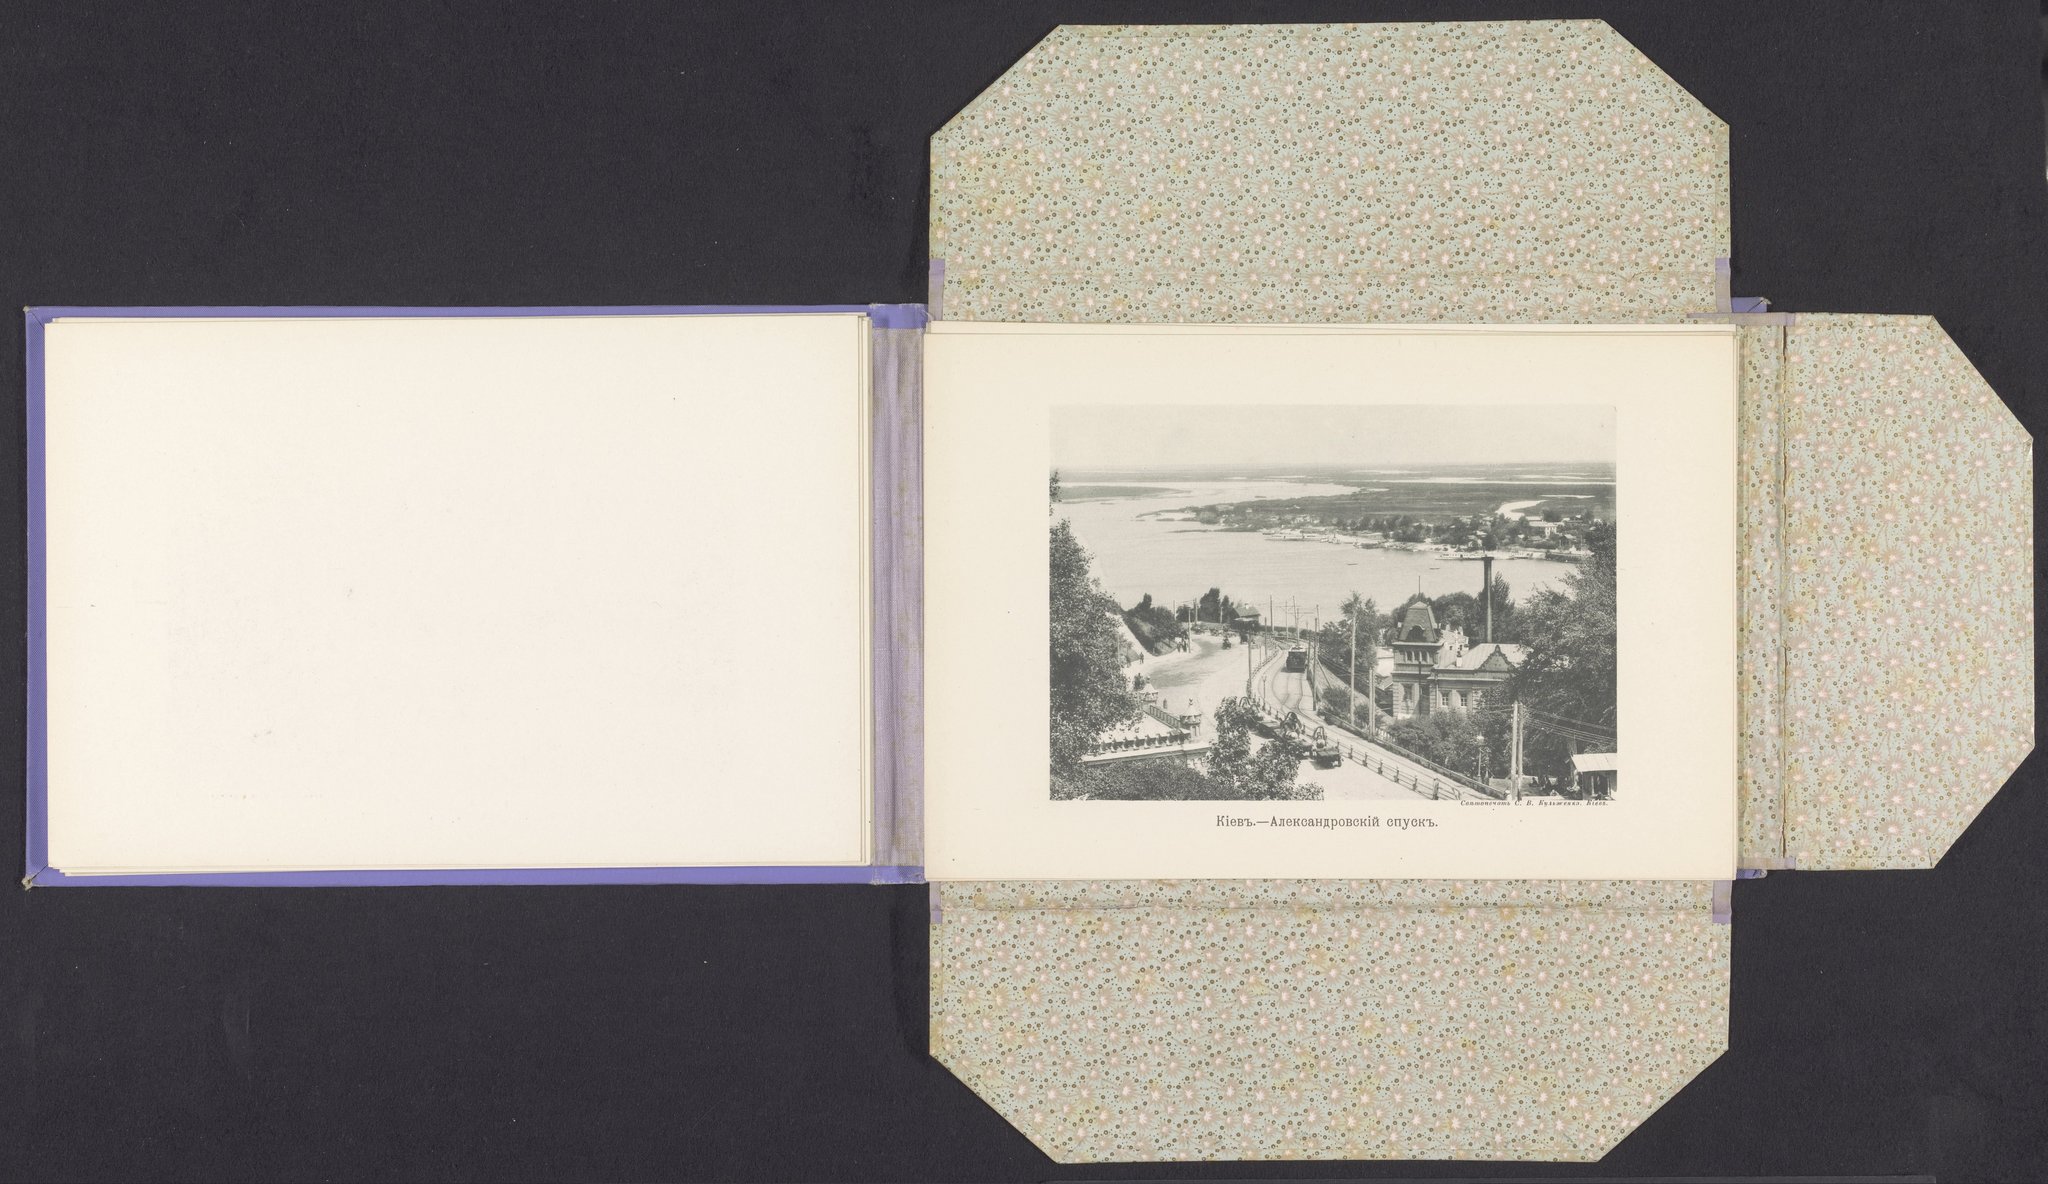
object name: photomechanical print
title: Gezicht op een weg naar de Dnjepr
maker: Anonymous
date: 1886-1896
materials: paper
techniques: photograph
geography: kyiv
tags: river, public road